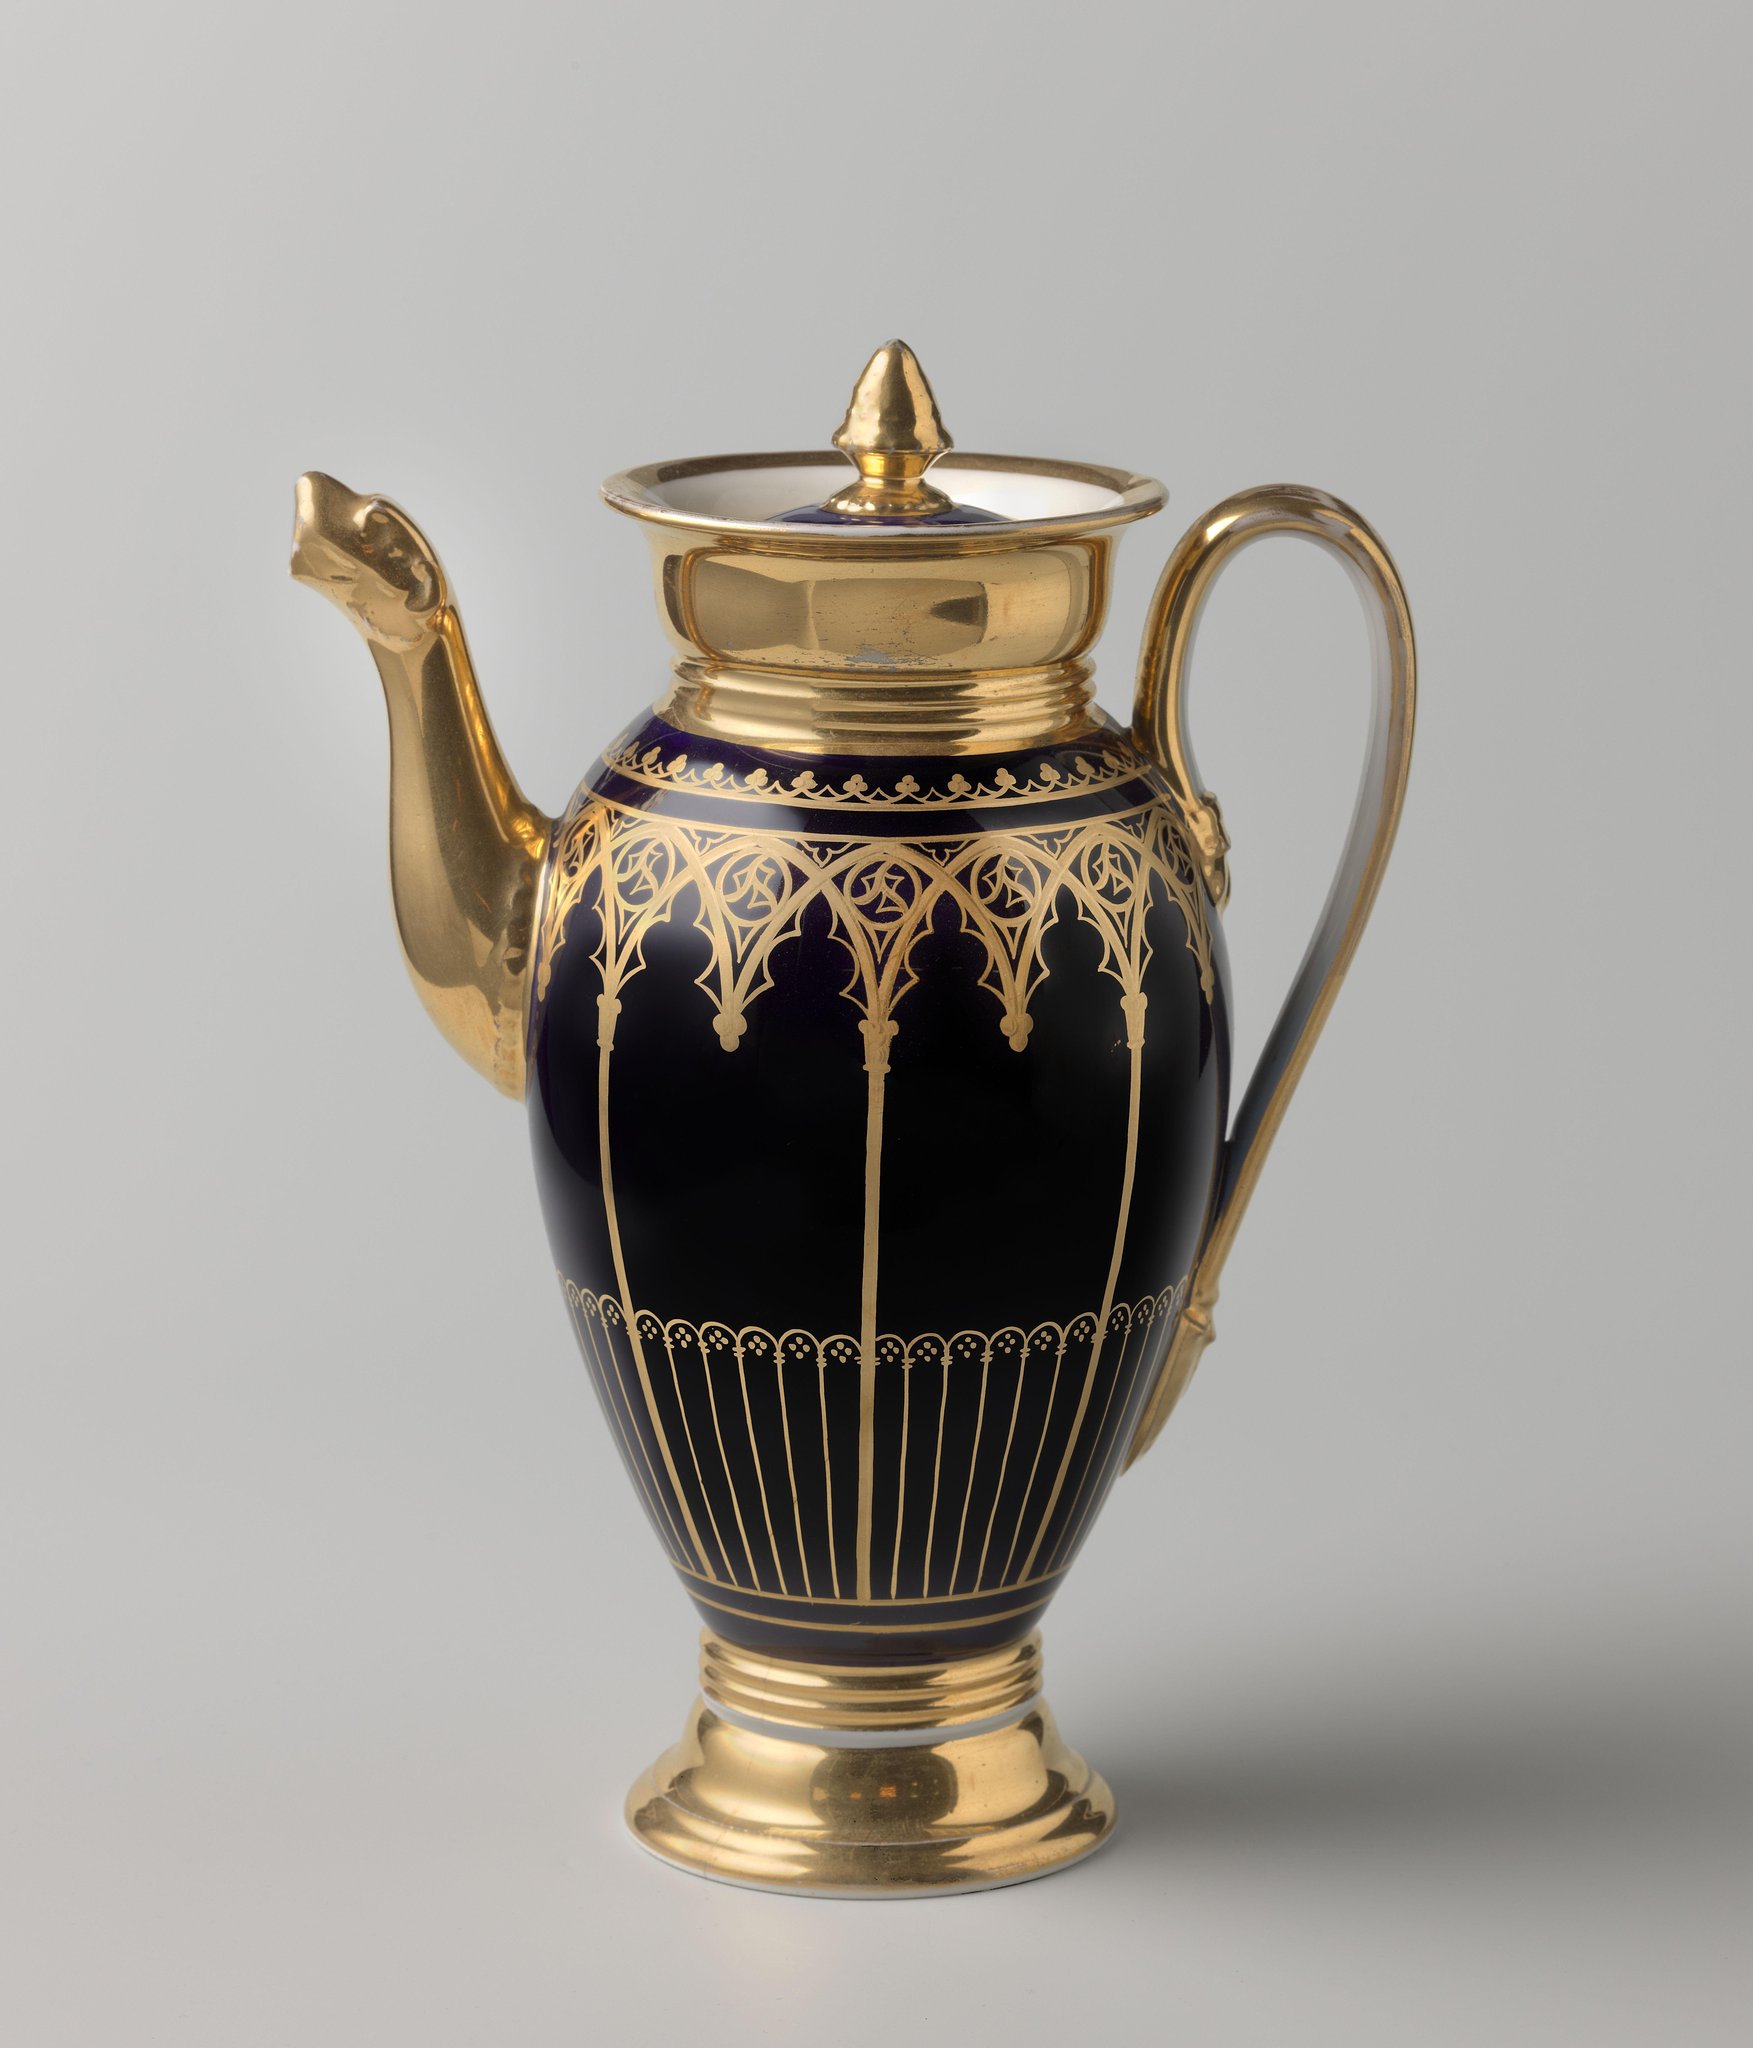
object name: lid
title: Cover of a coffeepot with a gothic arcade decoration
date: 1800-1899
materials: cobalt, glaze, gold, paint, porcelain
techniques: firing, forming, gilding, turning, vitrification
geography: saint-yrieix-la-perche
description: Deksel van koffiekan van porselein, deel van een servies, beschilderd in goud op een koningsblauw fond met een arcademotief met gotische traceringen. Buiten dit decor is het gehele oppervlak verguld. Merken: zie algemeen record.